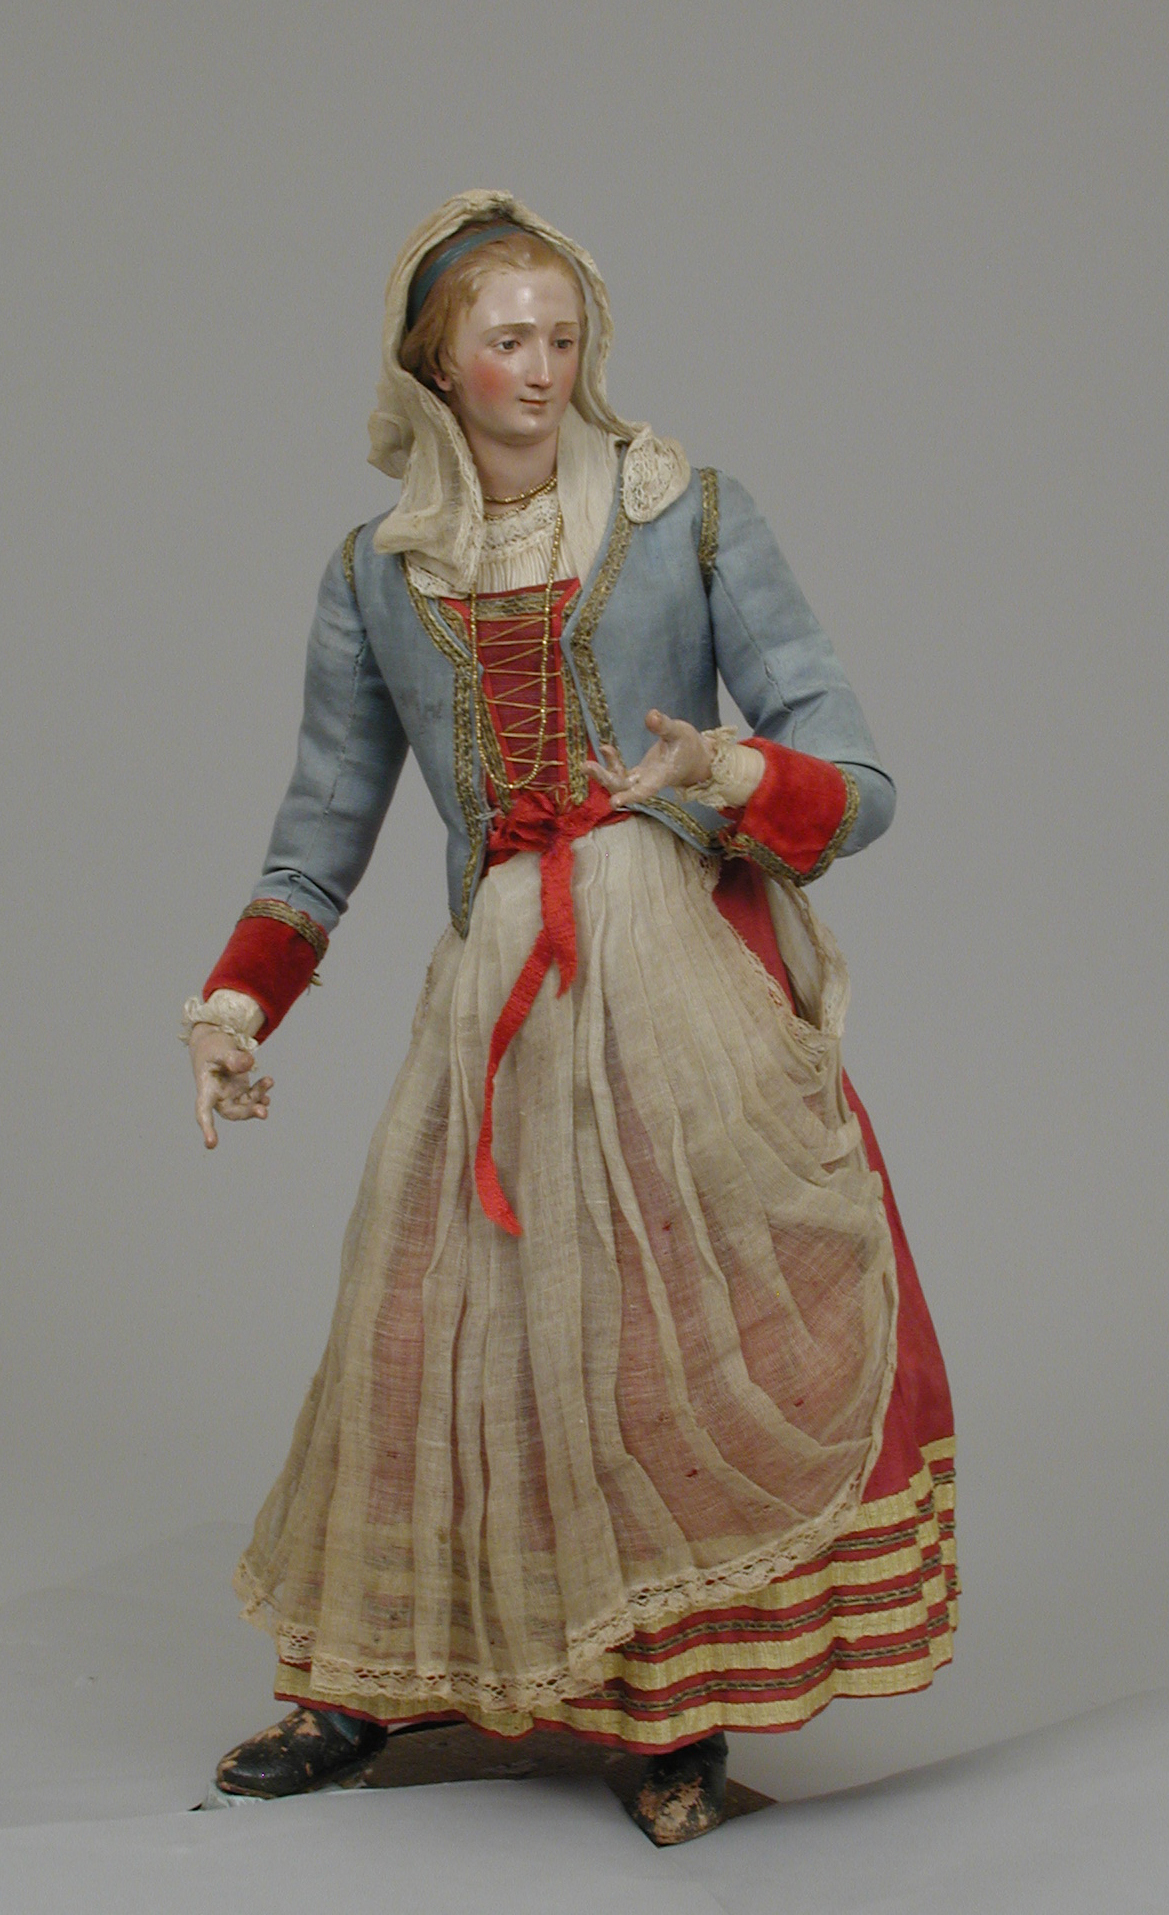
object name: crèche figure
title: Woman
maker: lorenzo mosca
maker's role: maker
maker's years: 1689-1789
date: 1751-1800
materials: lace, terracotta, fiber, metal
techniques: polychrome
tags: women